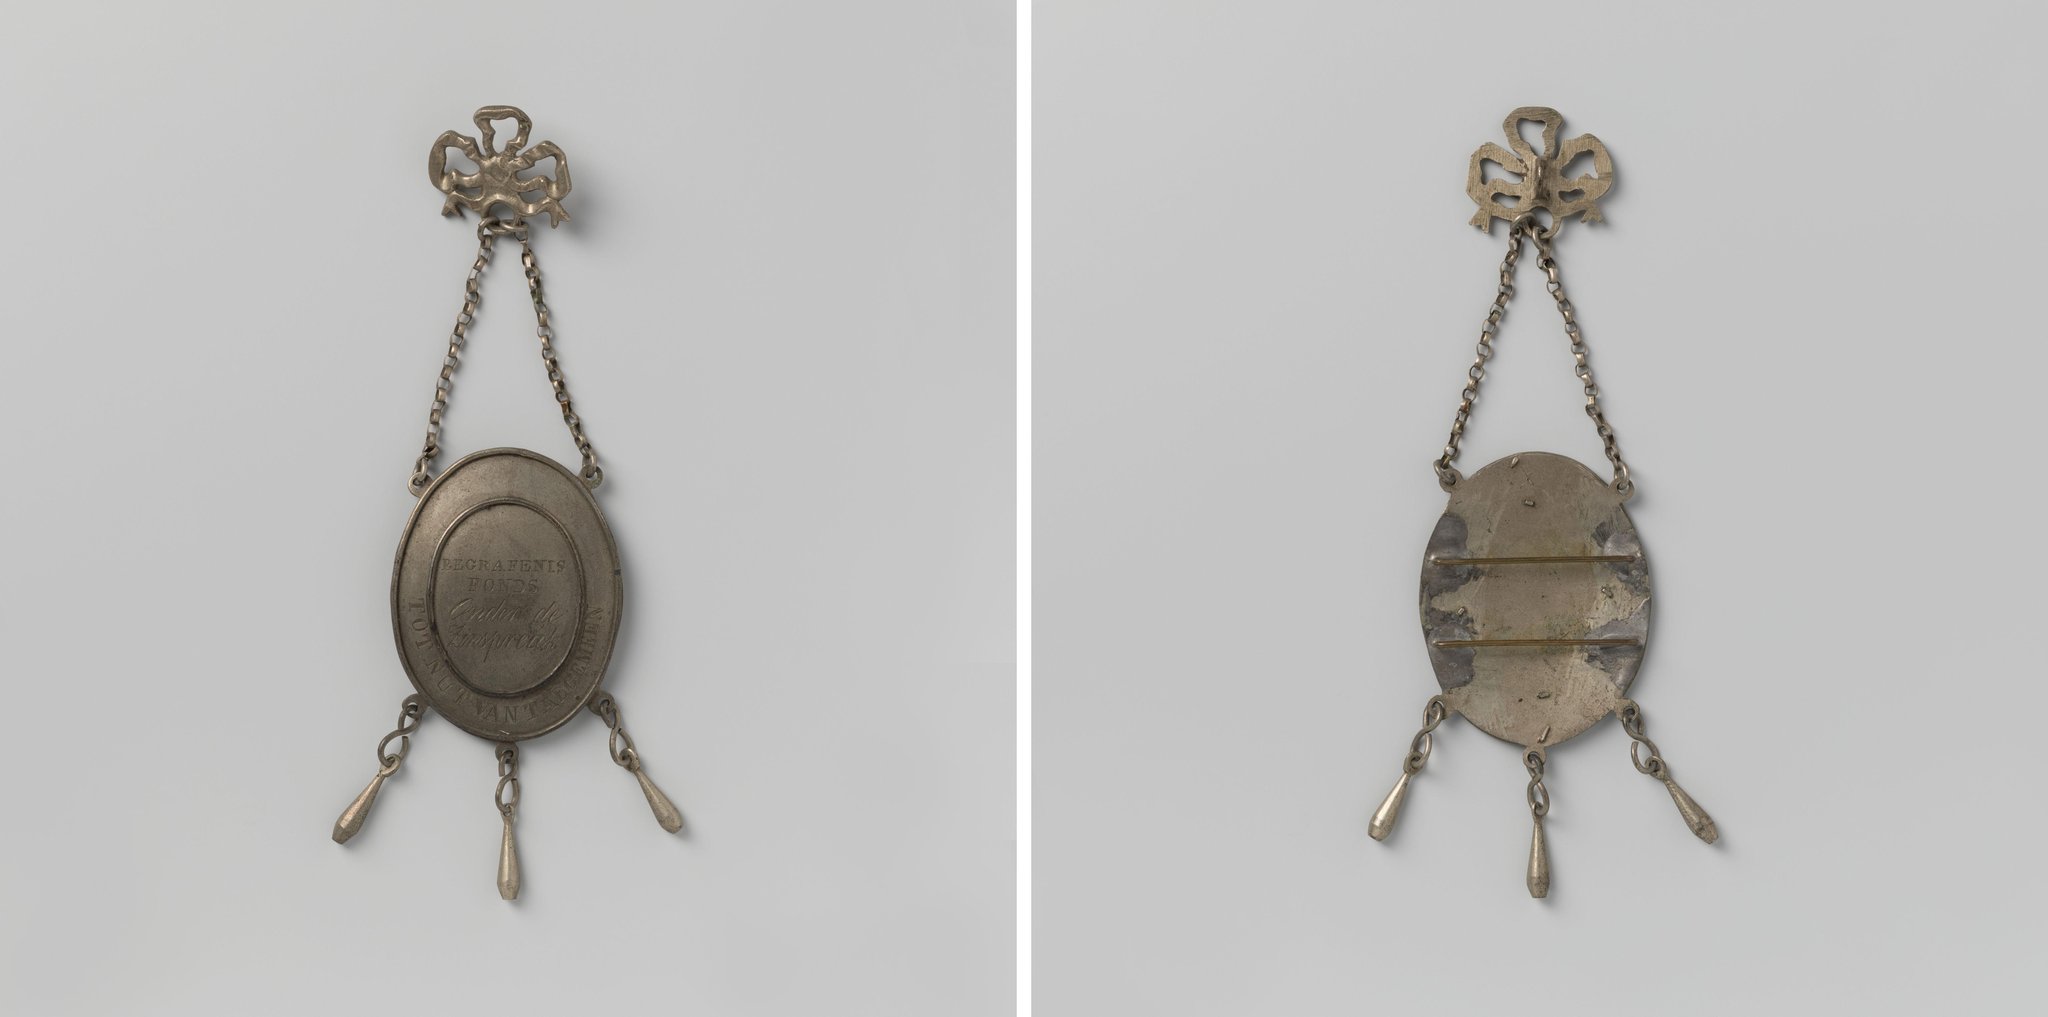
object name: bodebus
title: Begrafenisfonds onder de zinspreuk "Tot nut van 't algemeen"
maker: Anonymous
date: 1790-1850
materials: silver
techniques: engraving, soldering, striking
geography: netherlands